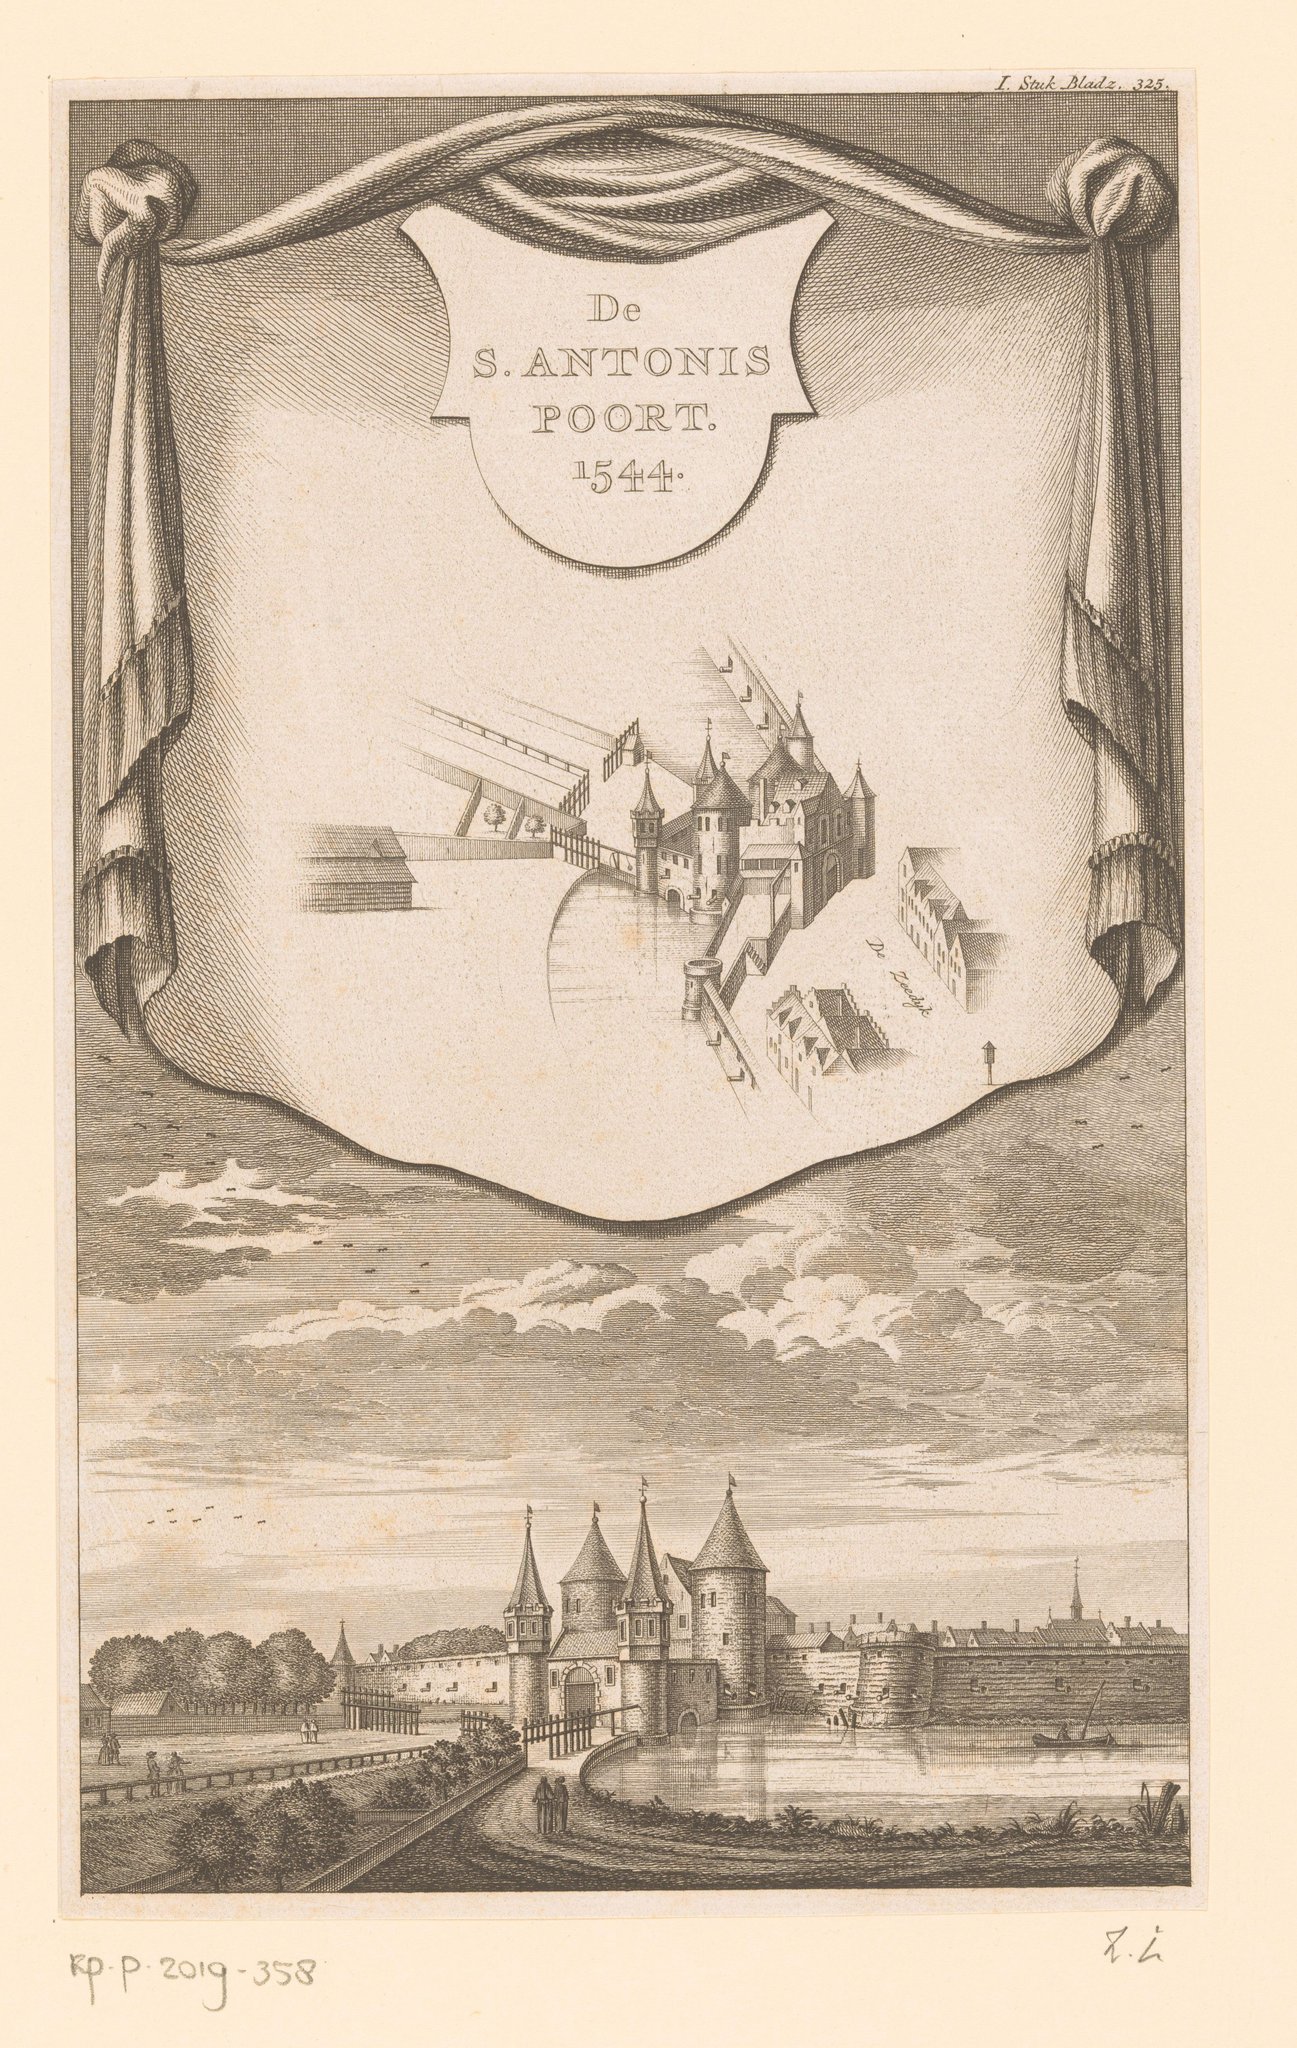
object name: book illustration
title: De S. Antonis poort 1544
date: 1760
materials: paper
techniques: engraving, etching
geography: amsterdam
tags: bridge in city across river, canal, etc., city-gate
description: Prent uit: Wagenaar, Jan. Amsterdam, in zyne opkomst, aanwas, geschiedenissen (...). 2 dln. Amsterdam: Isaak Tirion, 1760, dl. 1, p. 325.